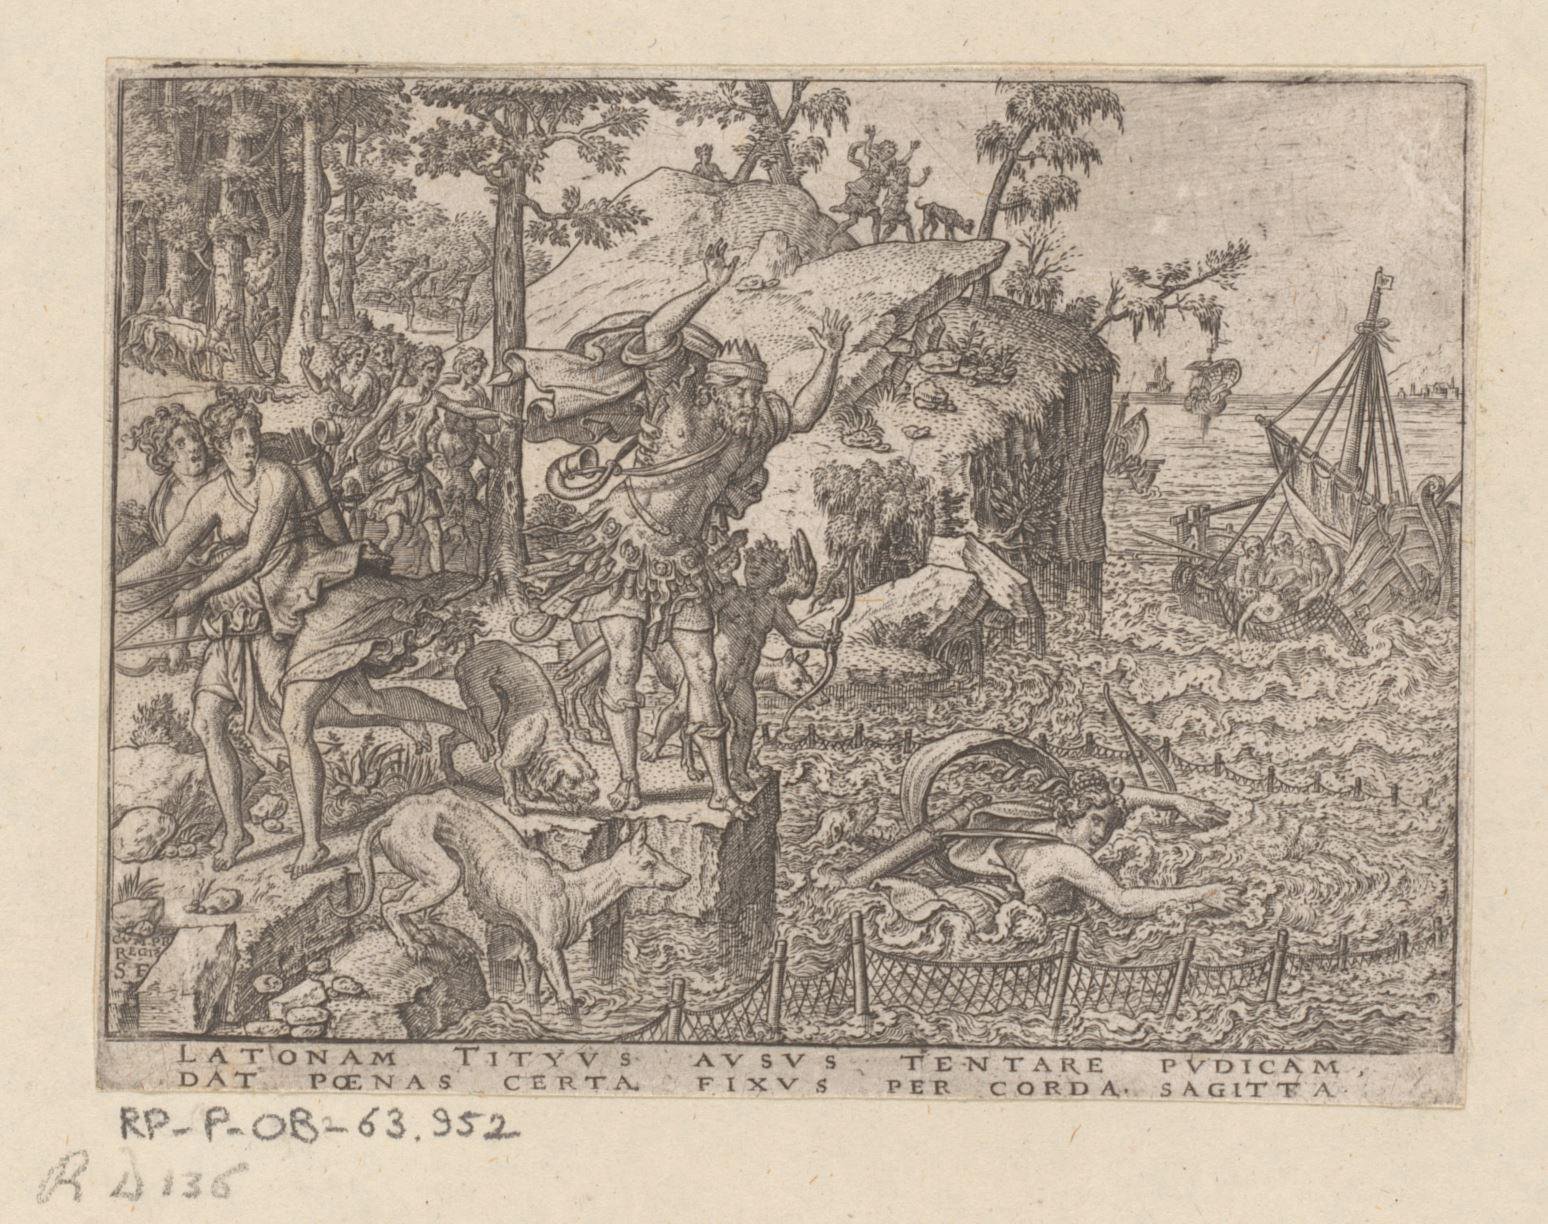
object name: print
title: Histoire d'Apollon et de Diane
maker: etienne delaune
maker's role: draughtsman, goldsmith, print maker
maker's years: 1519-1583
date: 1547-1548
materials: paper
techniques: engraving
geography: france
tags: (story of) minos, king of crete, britomartis, running away from minos, jumps from a cliff into the sea, story of britomartis and minos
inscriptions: collector's mark: Lugt 240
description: Maakt deel uit van een zesdelige serie met scènes uit het verhaal van Diana en Apollo.